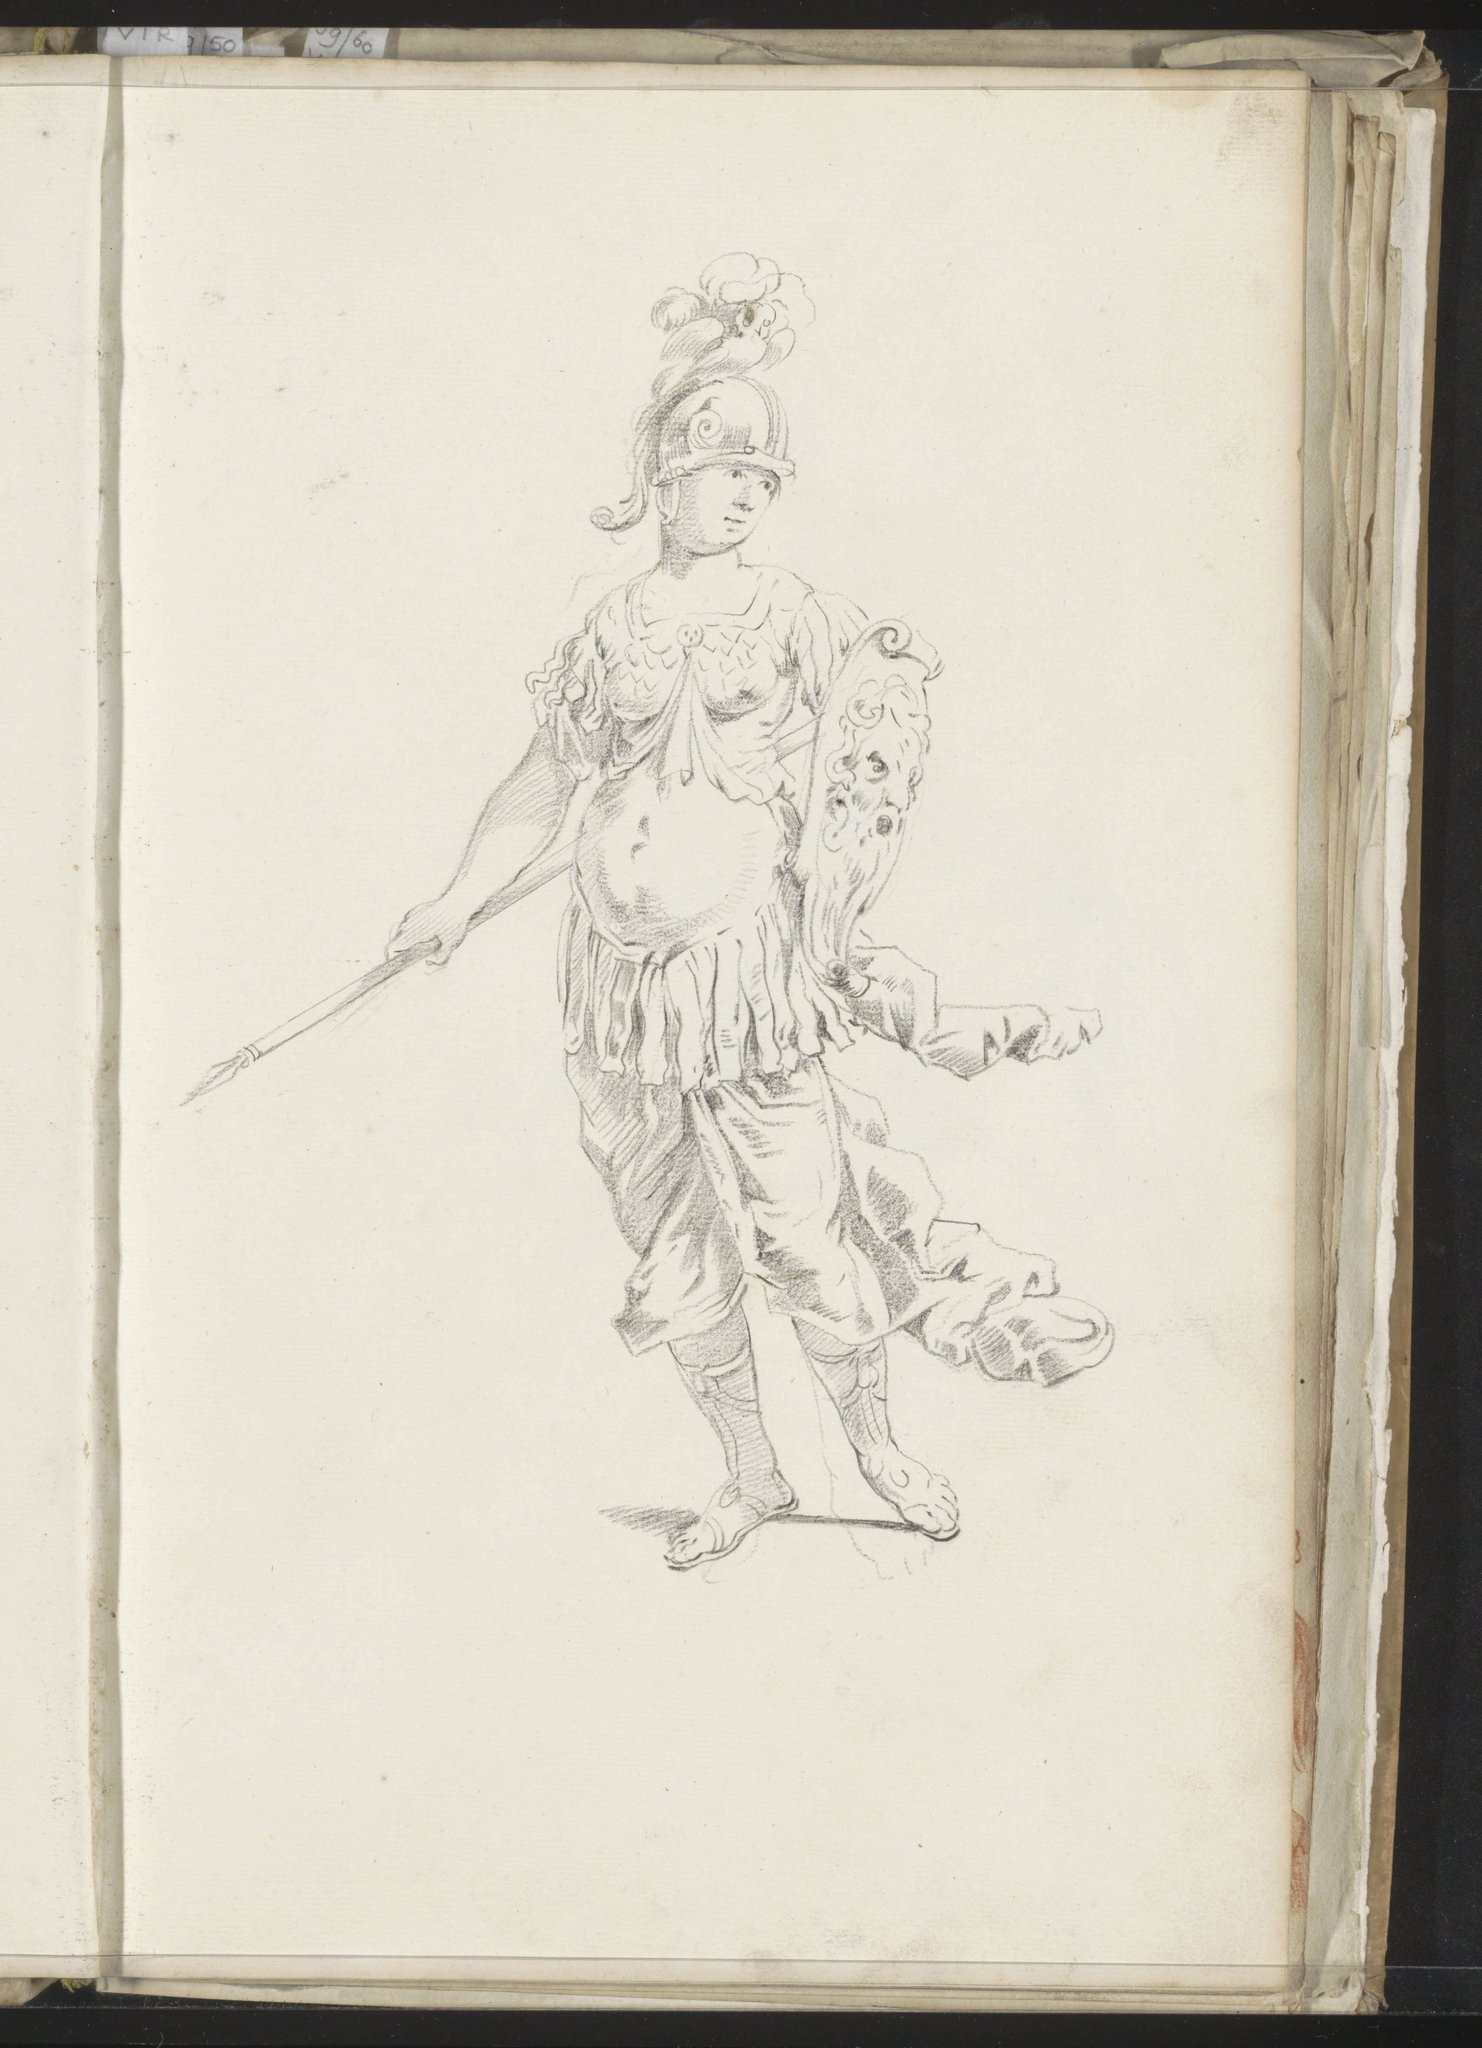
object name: sketchbook leaf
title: Minerva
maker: jacob toorenvliet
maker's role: draughtsman, painter, print maker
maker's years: 1640-1719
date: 1701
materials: chalk, paper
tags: (story of) minerva (pallas, athena)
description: Minerva in wapenrusting met een speer, helm en schild. Blad 20 recto uit een schetsboek met 63 bladen.